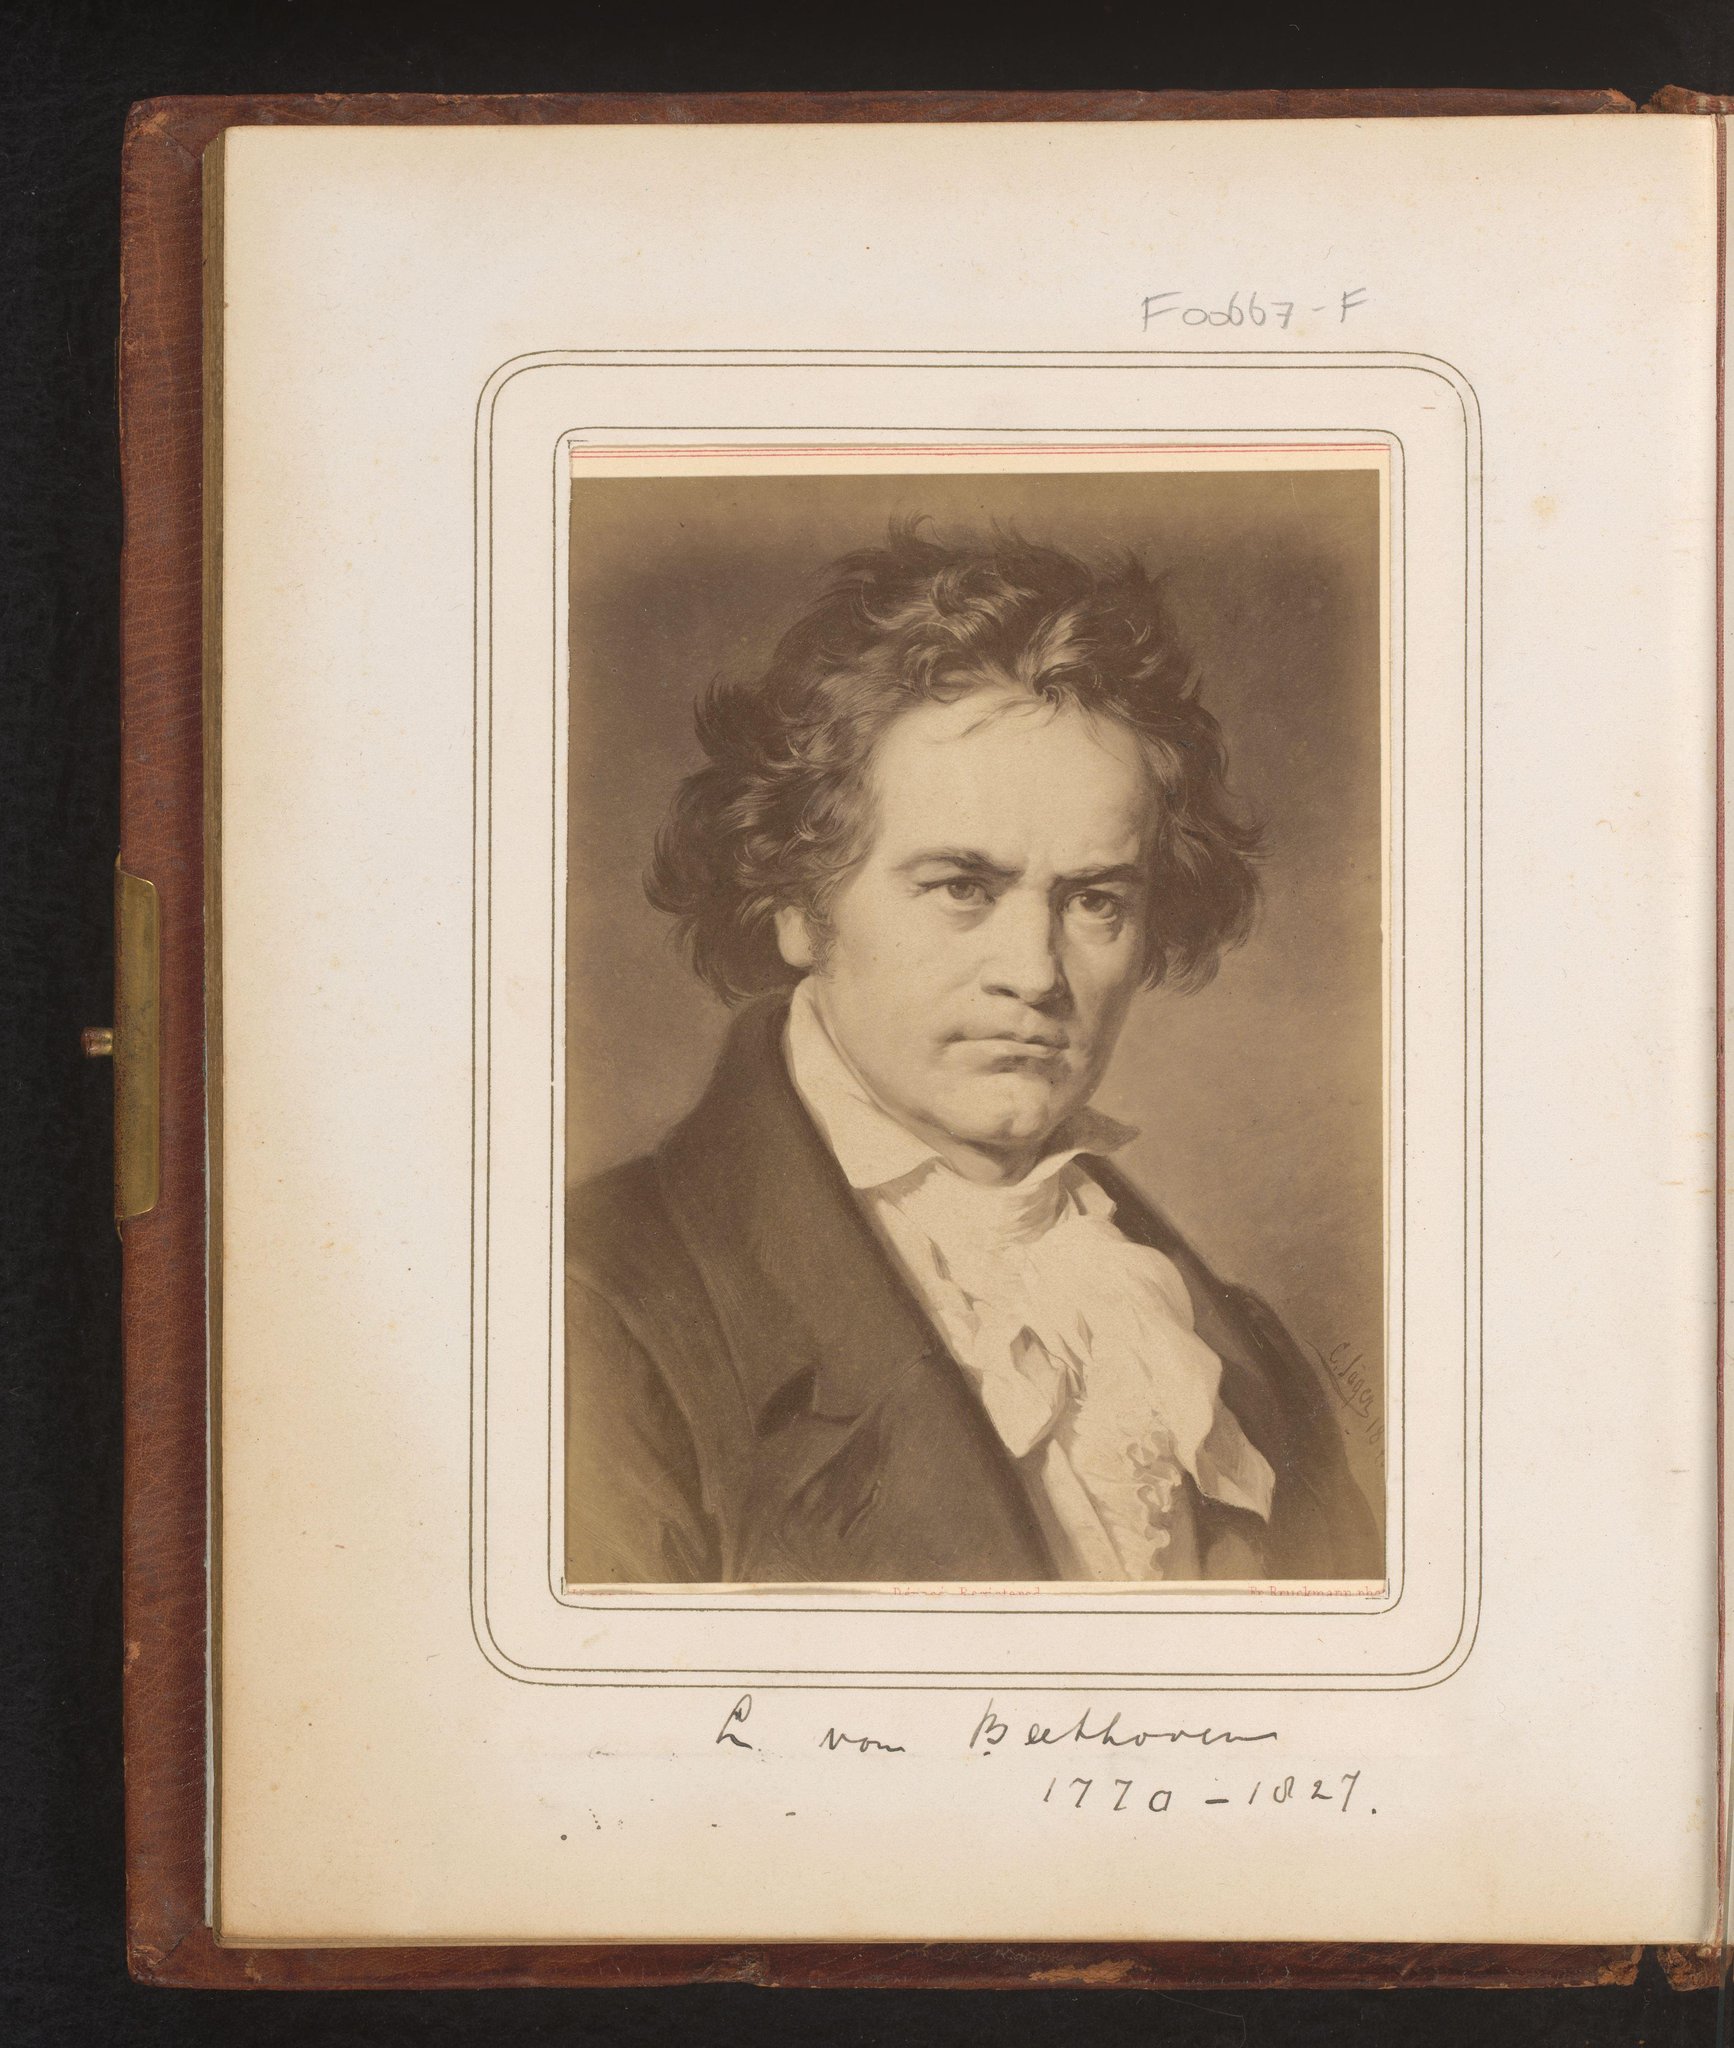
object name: cabinet photograph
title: Fotoreproductie van een geschilderd portret van Ludwig van Beethoven door Carl Jaeger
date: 1870-1890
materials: cardboard, photographic support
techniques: albumen print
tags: historical persons, portrait of composer, picture, painting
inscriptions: annotation: ‘L. von Beethoven/ 1770 - 1827’, name: ‘Jäger pinx. Déposé Registered/ Fr. Bruckmann pho[...]’